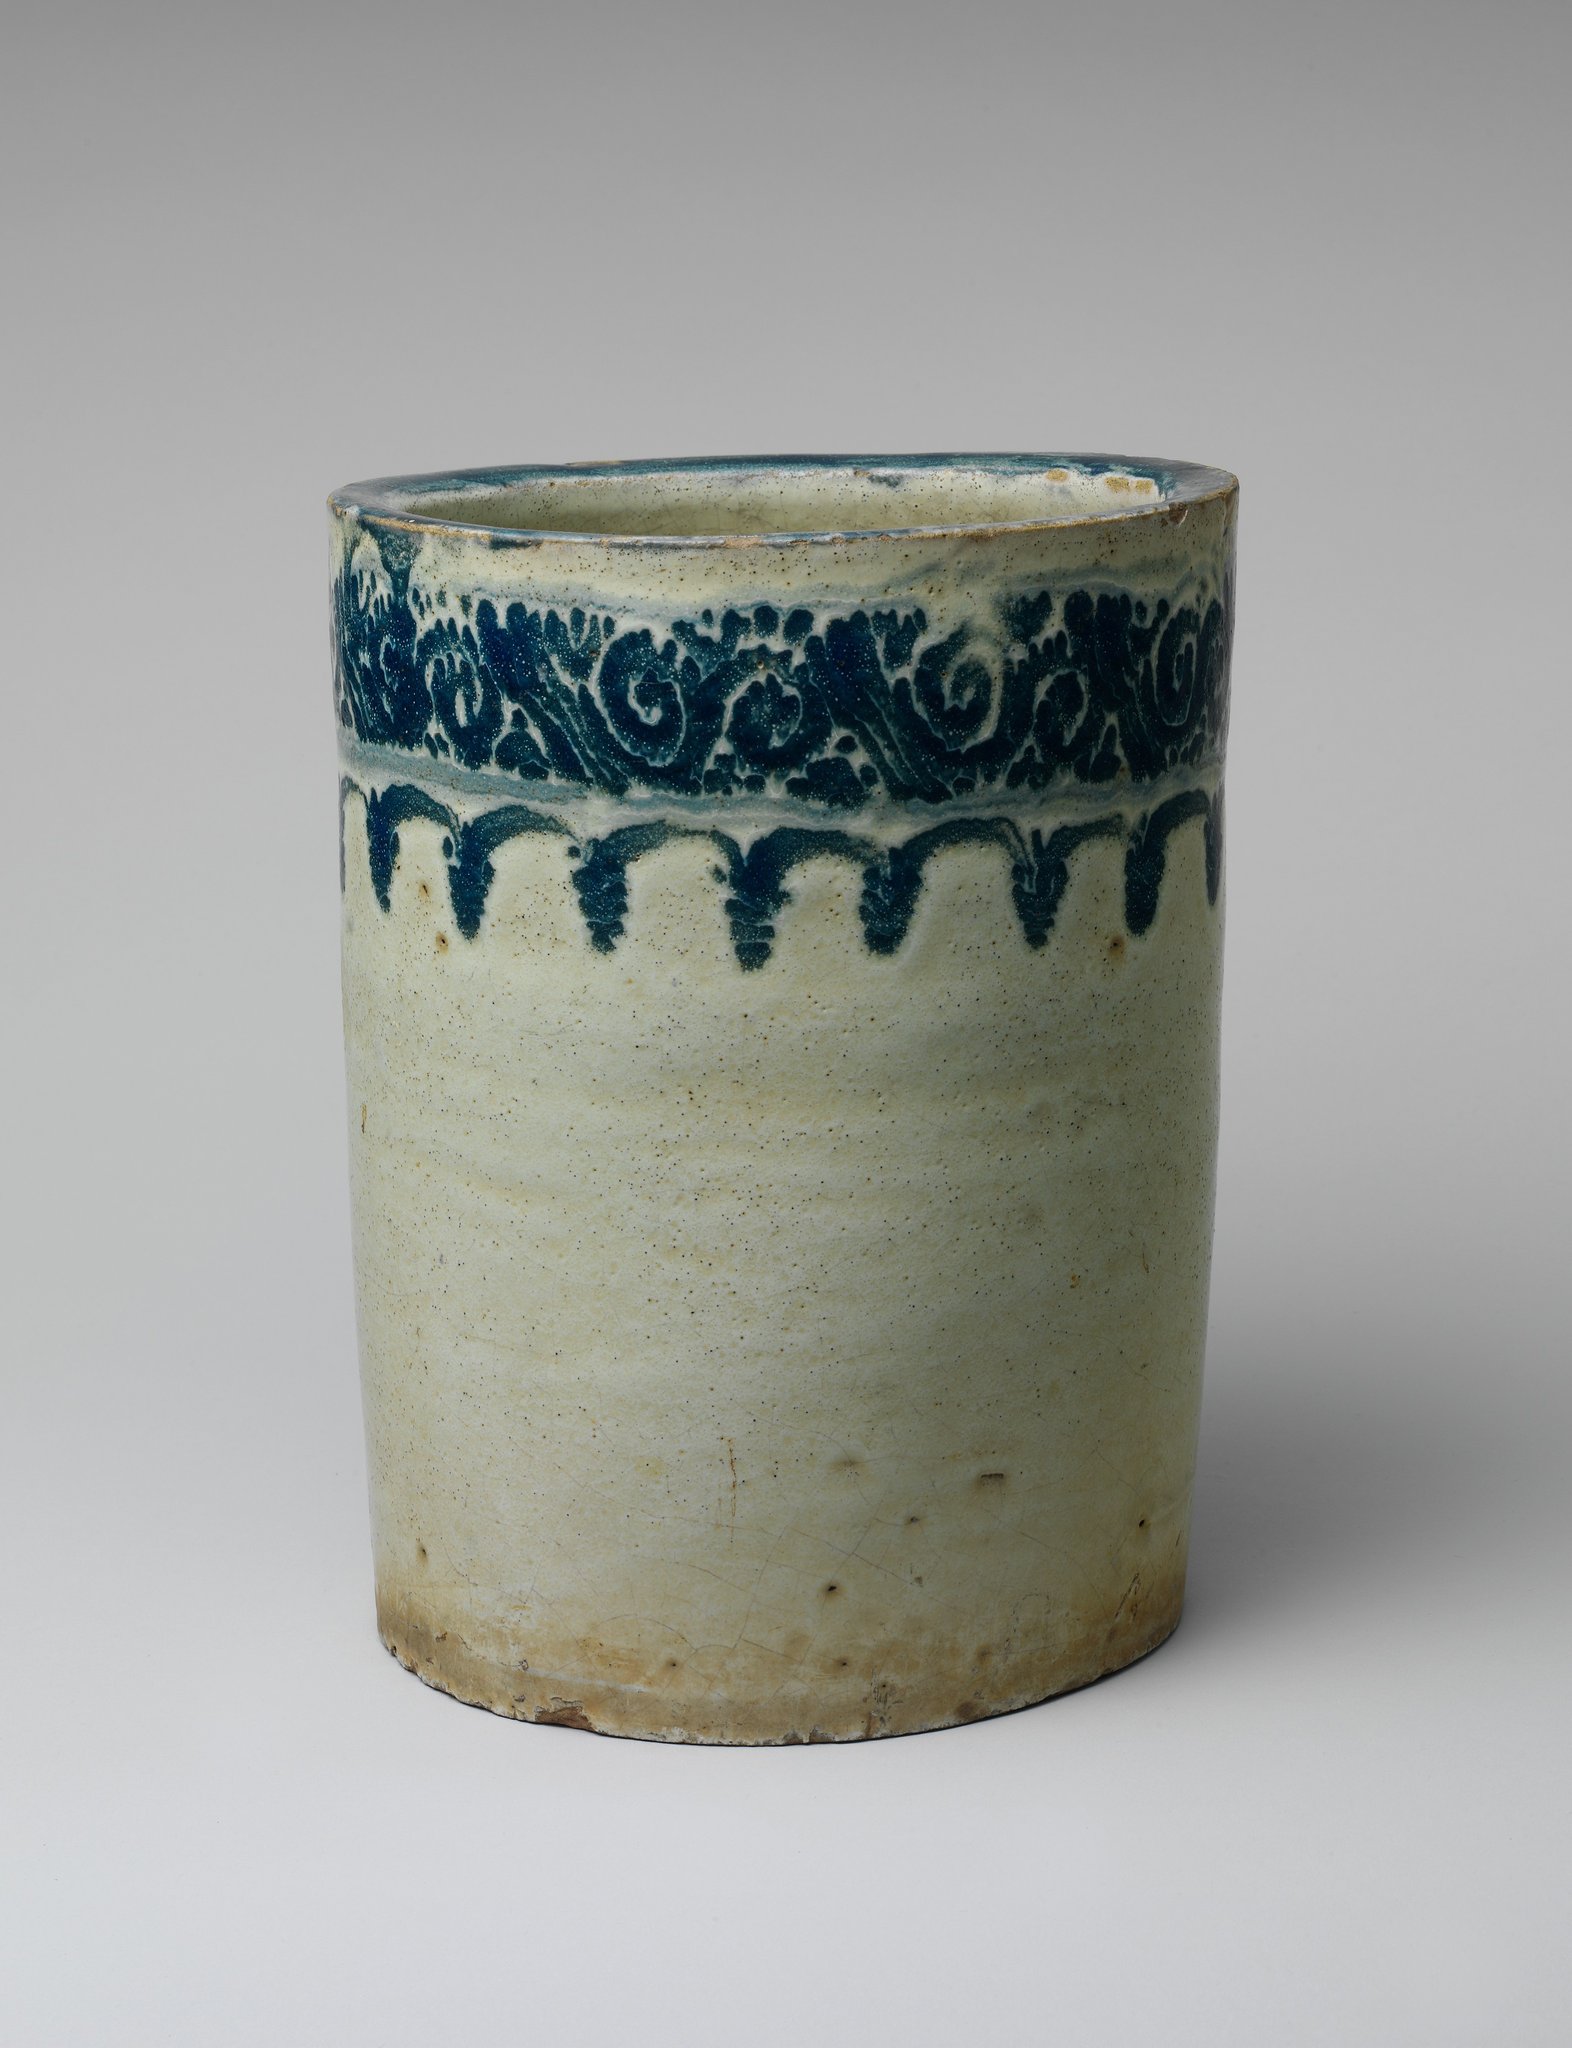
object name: jar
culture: mexican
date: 1750-1780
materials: earthenware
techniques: glazing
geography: mexico